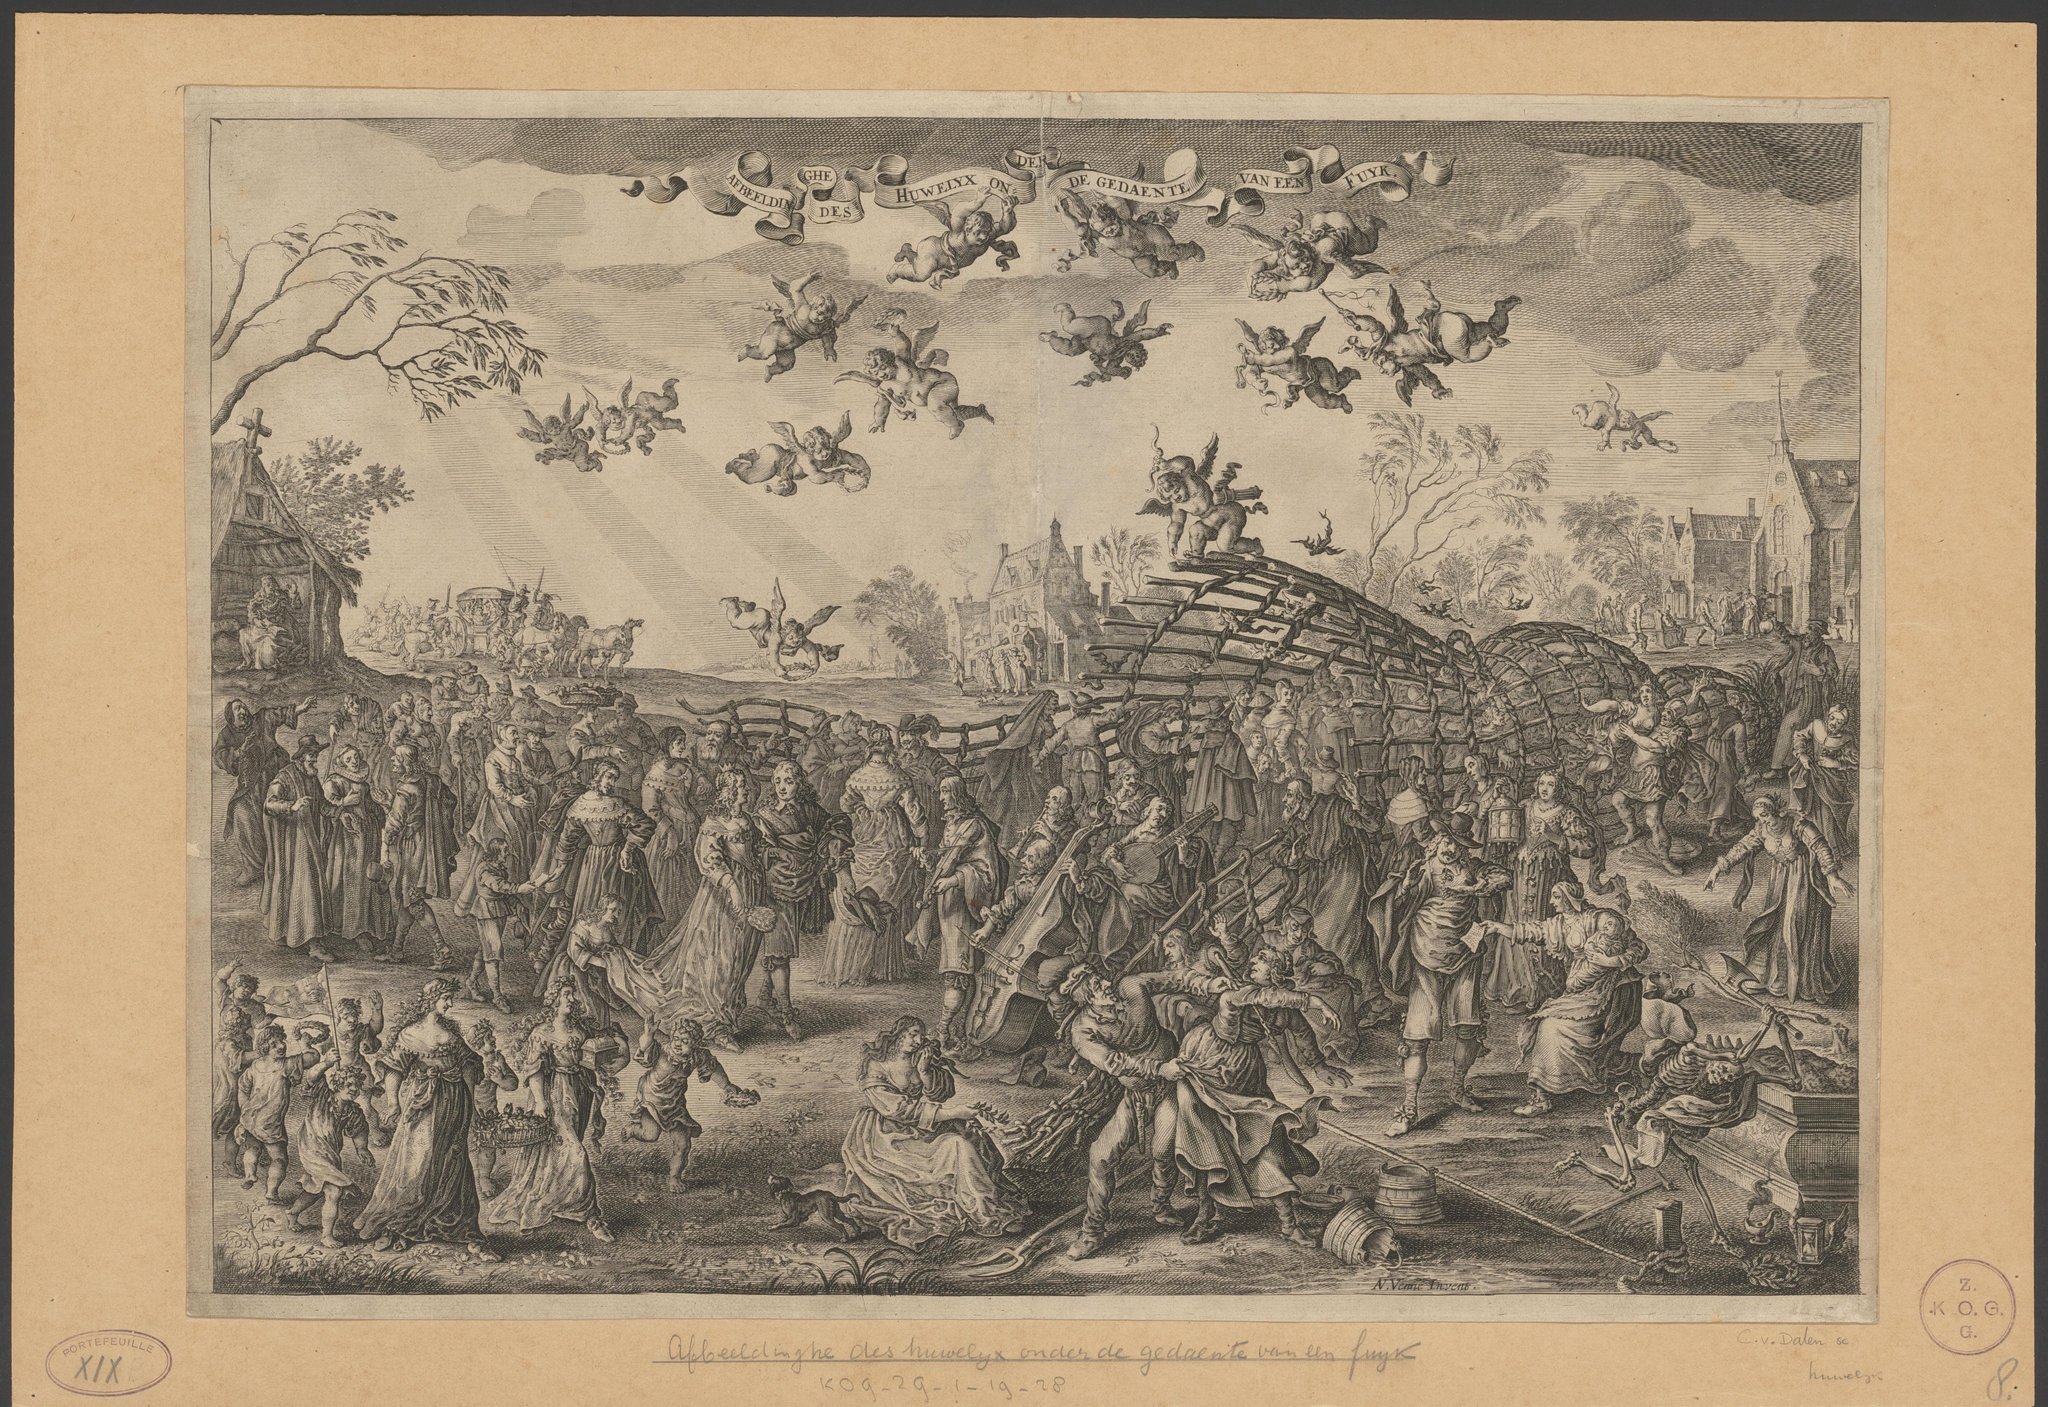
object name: print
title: De huwelijksfuik: allegorie op het huwelijk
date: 1655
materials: paper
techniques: engraving, etching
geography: northern netherlands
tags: marriage as trap, snare, etc., marriage, married couple, 'matrimonium'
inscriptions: collector's mark, collector's mark: Lugt 1641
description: De huwelijksfuik, allegorie op het huwelijk. Paren lopen gearmd een grote fuik of vangnet binnen onder begeleiding van muziek van een klein orkest. Bovenop de fuik zit Cupido. Putti dansen rond een bruidspaar met bloemenmand. Om de fuik lopen mannen en vrouwen, zij maken allerlei erotische toespelingen. rechts zwaait de Dood met een hakbijl. Op de voorgrond huilt een zittende Vrede en vechten een man en een vrouw met elkaar. Onderwerpsrubrieken binnen de Atlas Zeden en Gewoonten: Des Menschen Begin, Midden en Einde. Bruiloft en huwelijk.